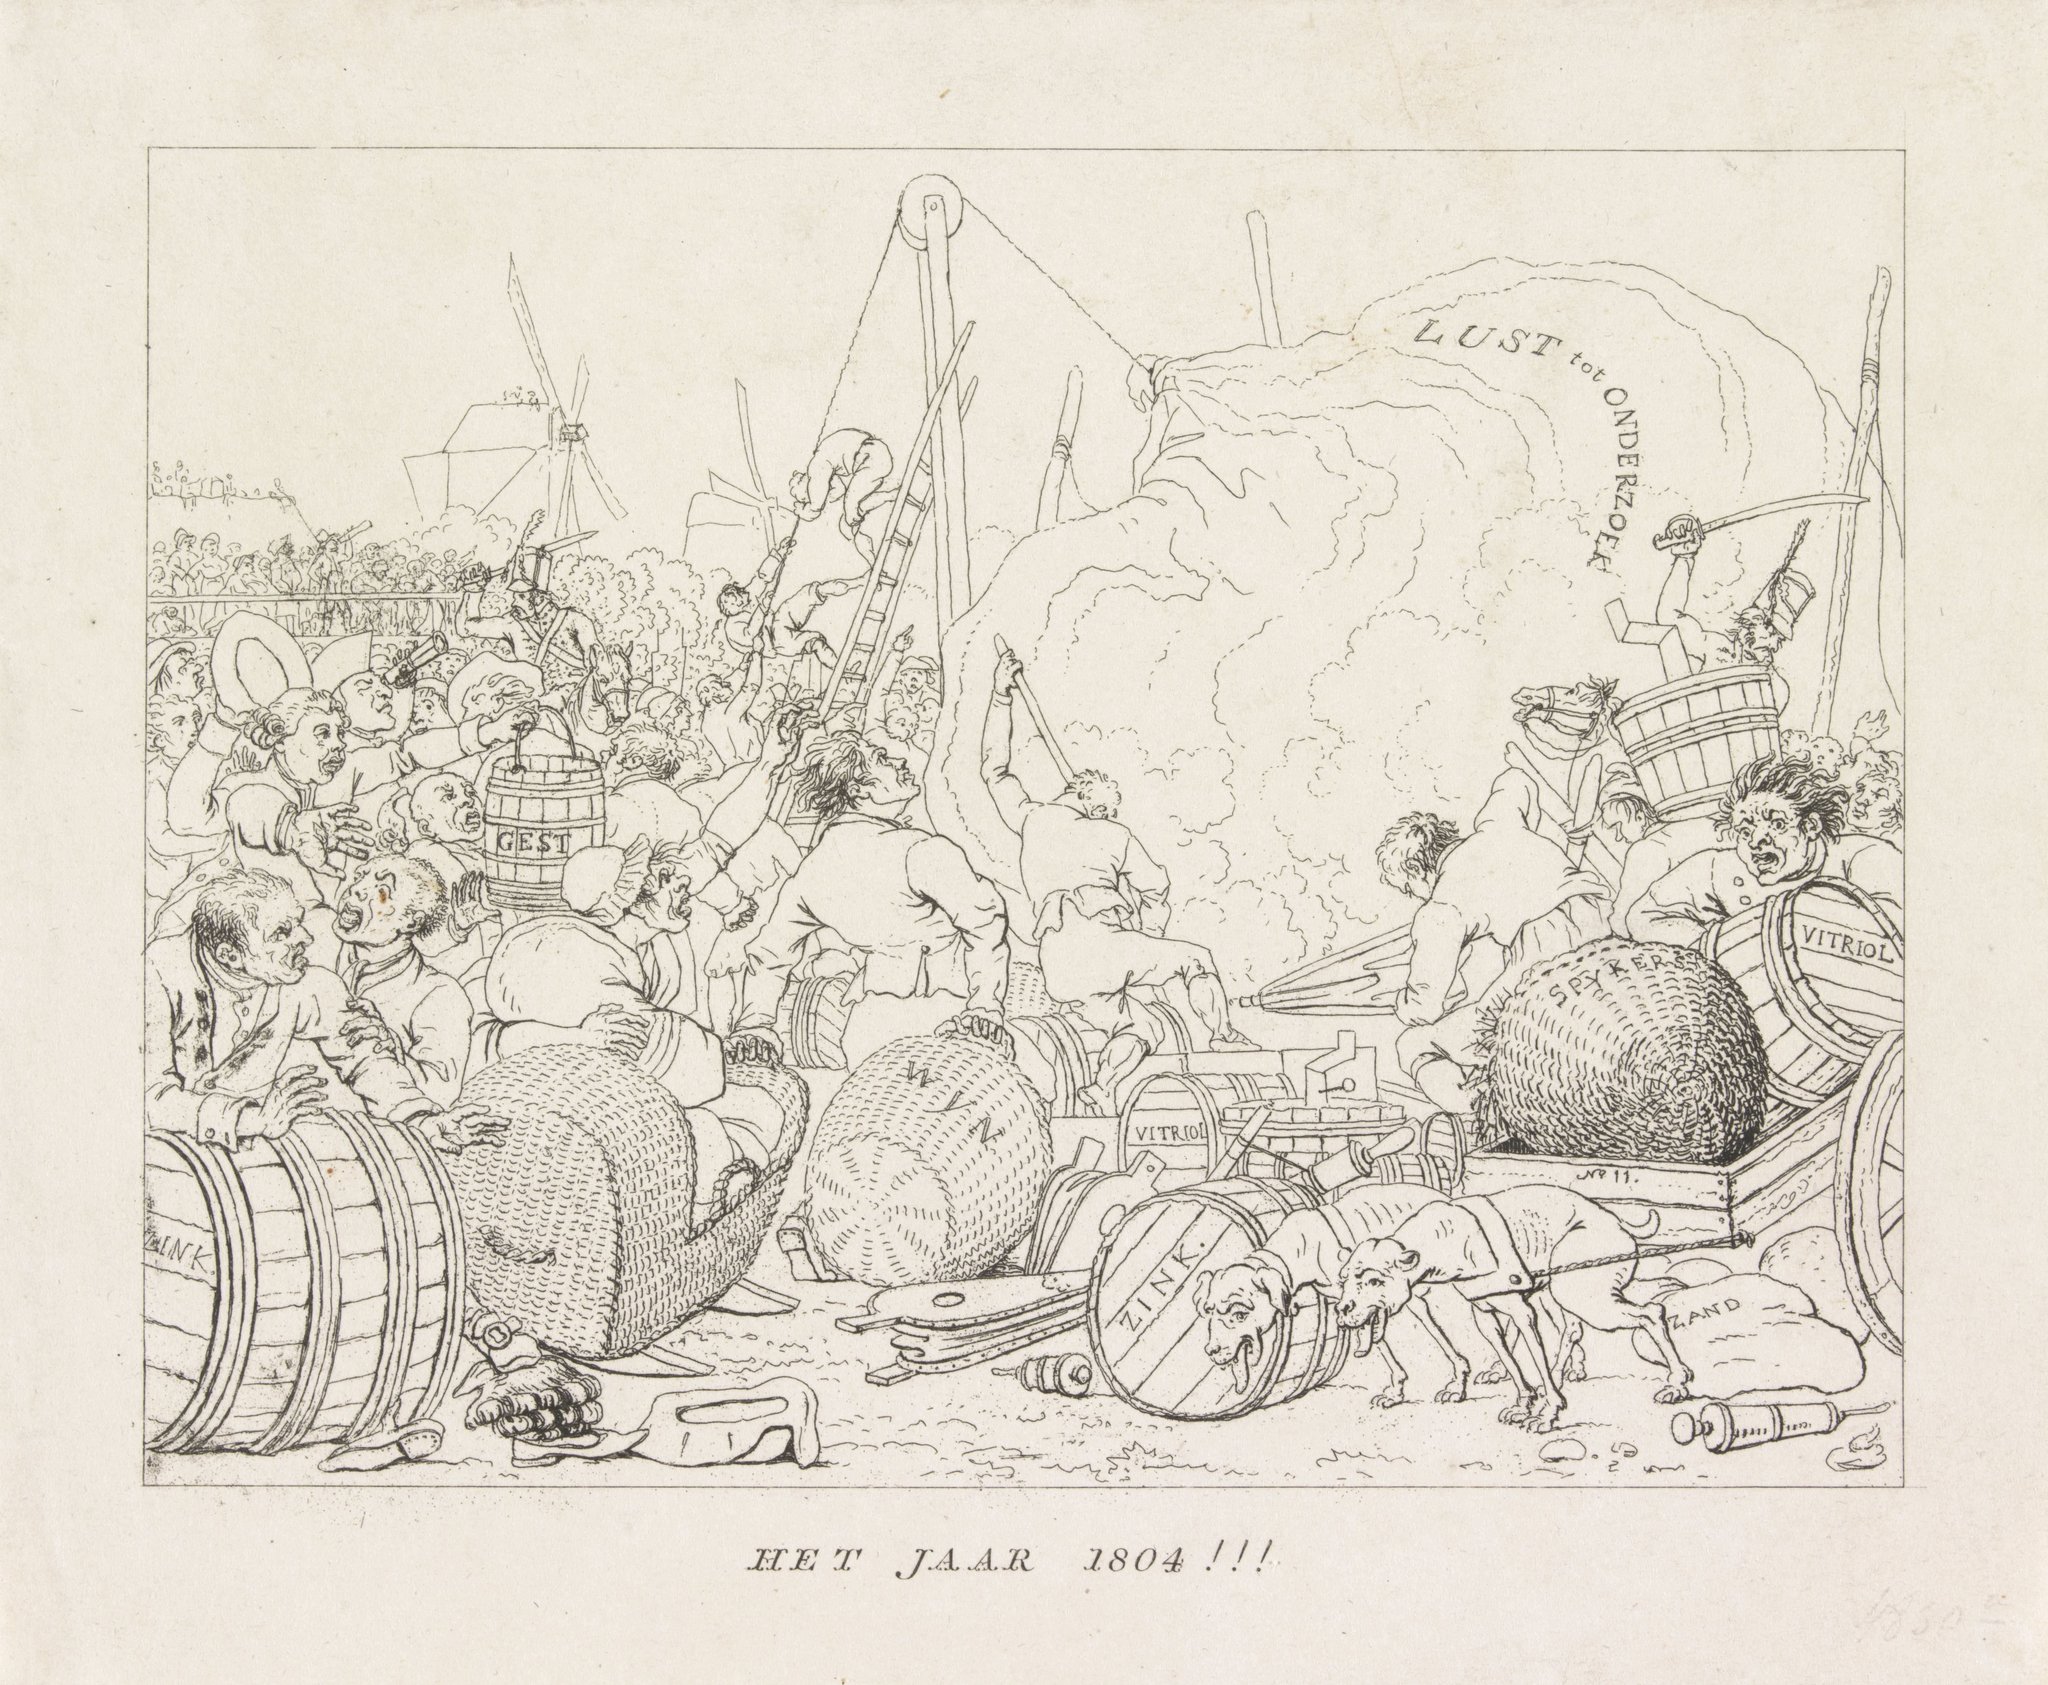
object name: print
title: Mislukte luchtreis van A. Hopman (plaat I), 1804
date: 1804-1805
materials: paper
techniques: etching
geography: netherlands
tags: leiden, balloon flight (sport)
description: Chaos op straat tijdens de onsuccesvolle pogingen om de luchtballon van Abraham Hopman en Louis Samuel Loude met hete lucht te vullen, op de Overtoom te Amsterdam op 5 juli 1804. Rechts een hondenkar met spijkers en vitriool. Hopman en Loude ondernamen op 5 en 6 juli 1804 pogingen om een reis te maken in een luchtballon genaamd 'Lust tot Onderzoek'. Uiteindelijk is de luchtballon zonder passagiers opgelaten. Zie ook de pendant.